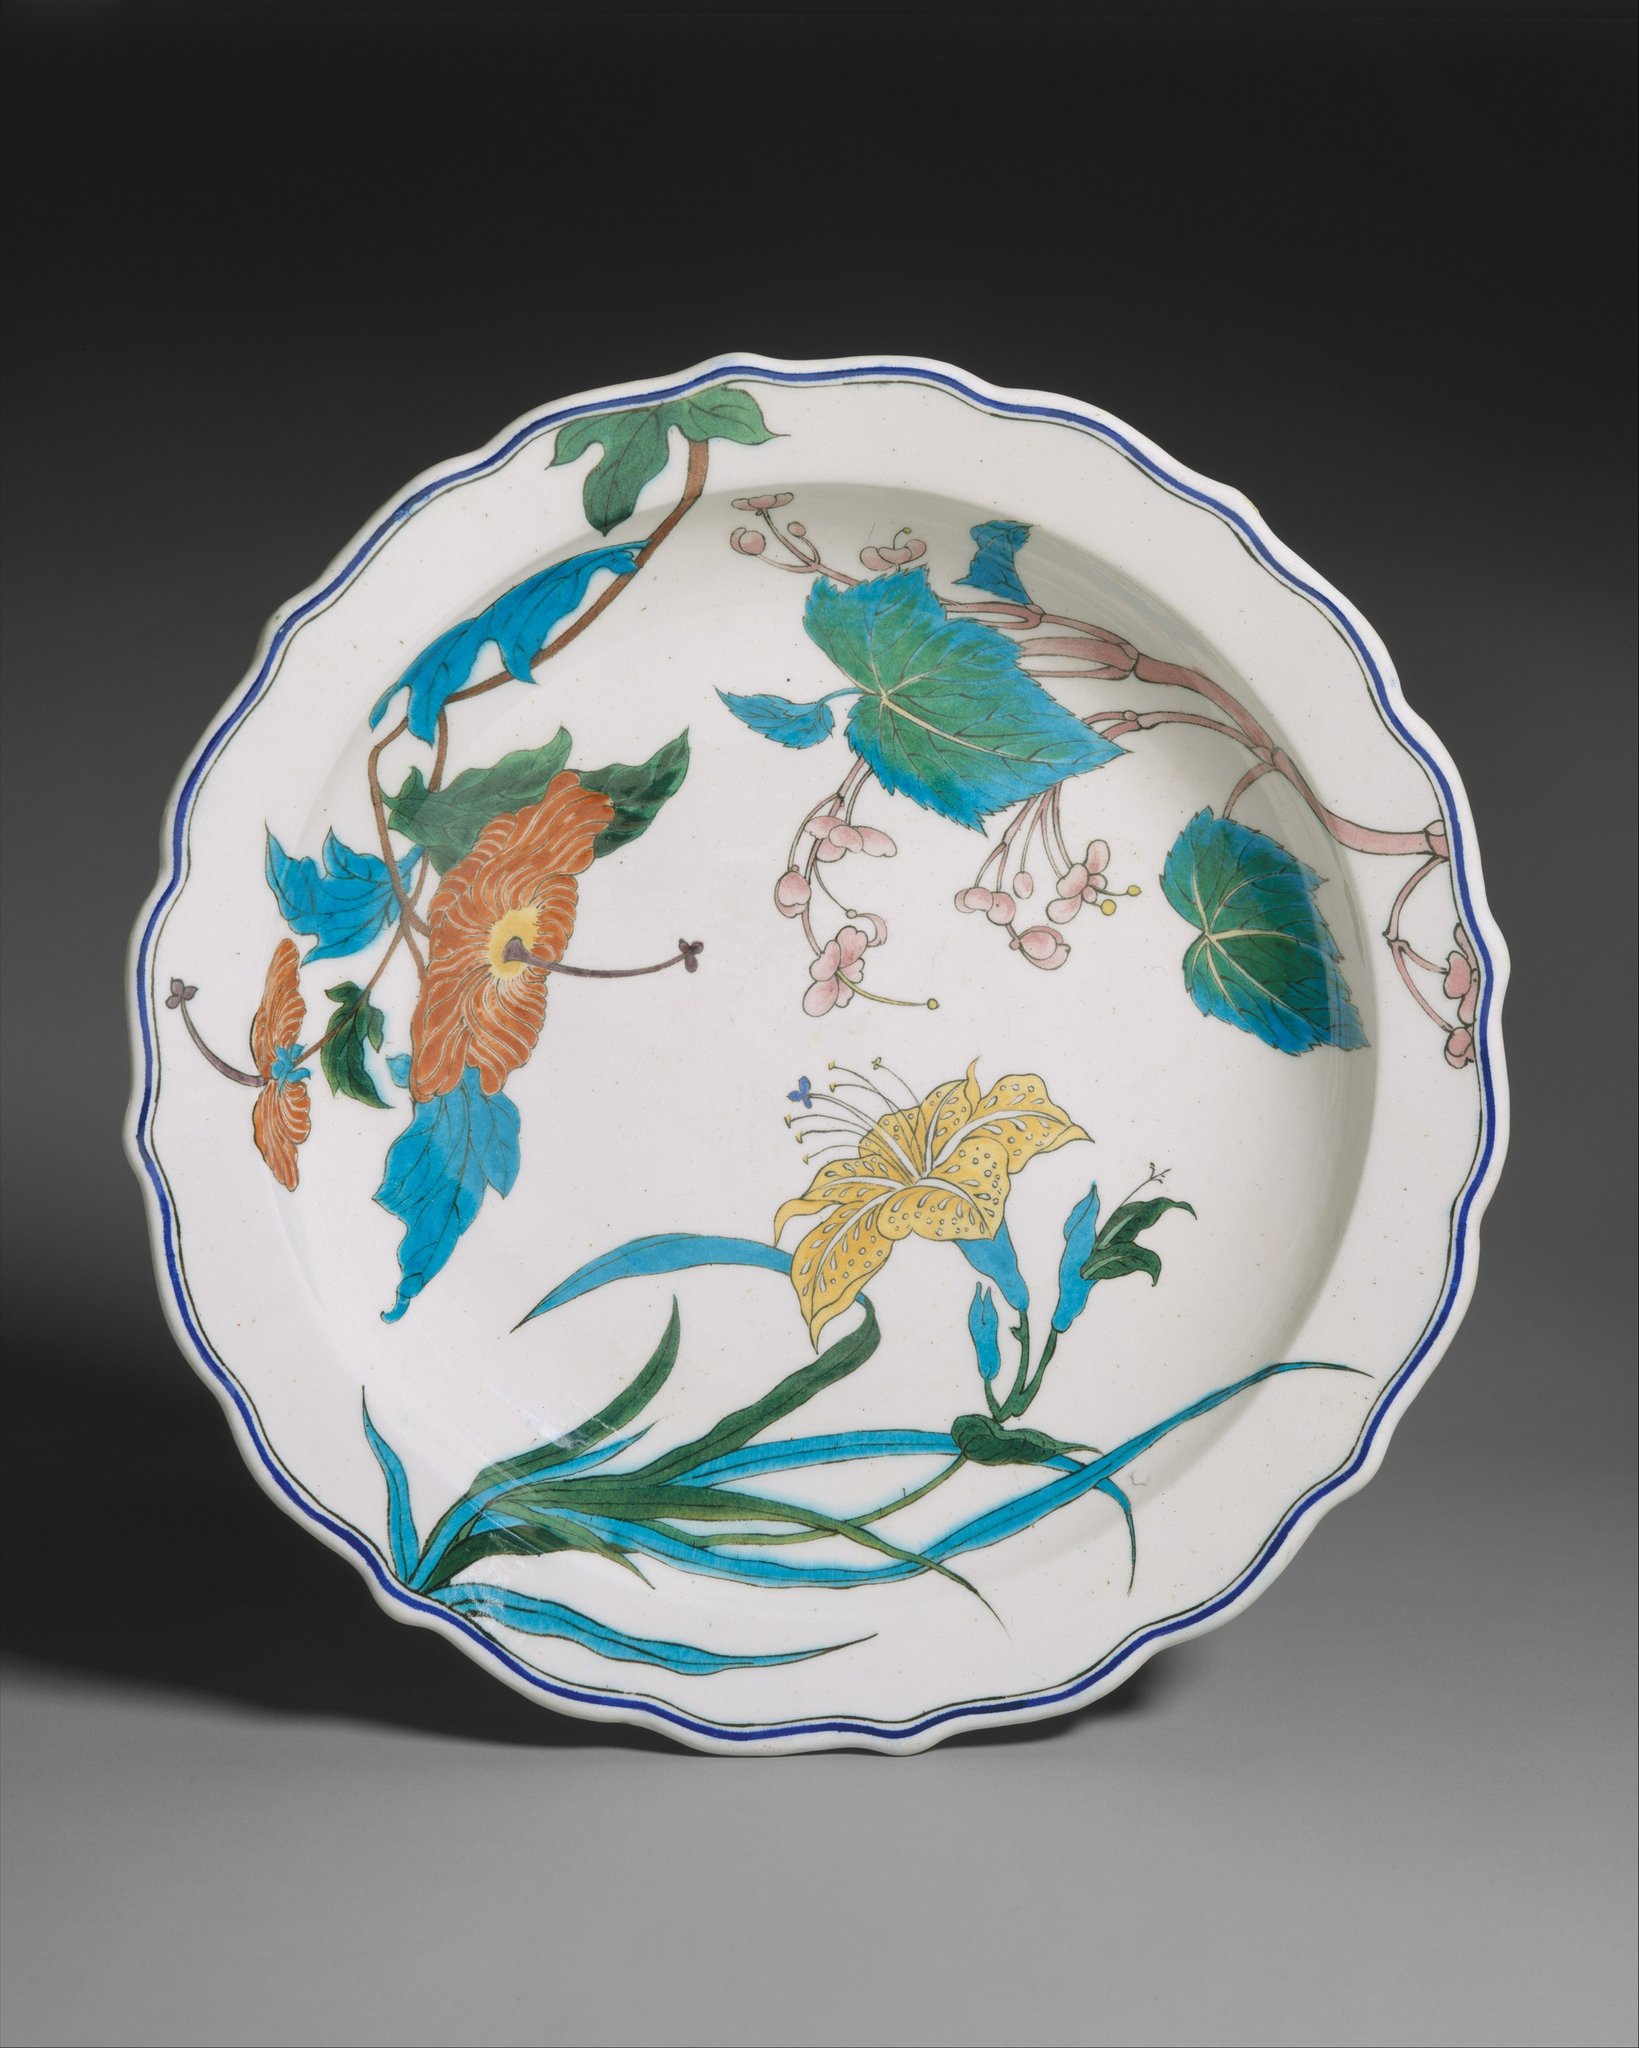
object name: dish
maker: joseph-théodore deck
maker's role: maker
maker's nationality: french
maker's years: 1823-1891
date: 1866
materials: earthenware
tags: flowers